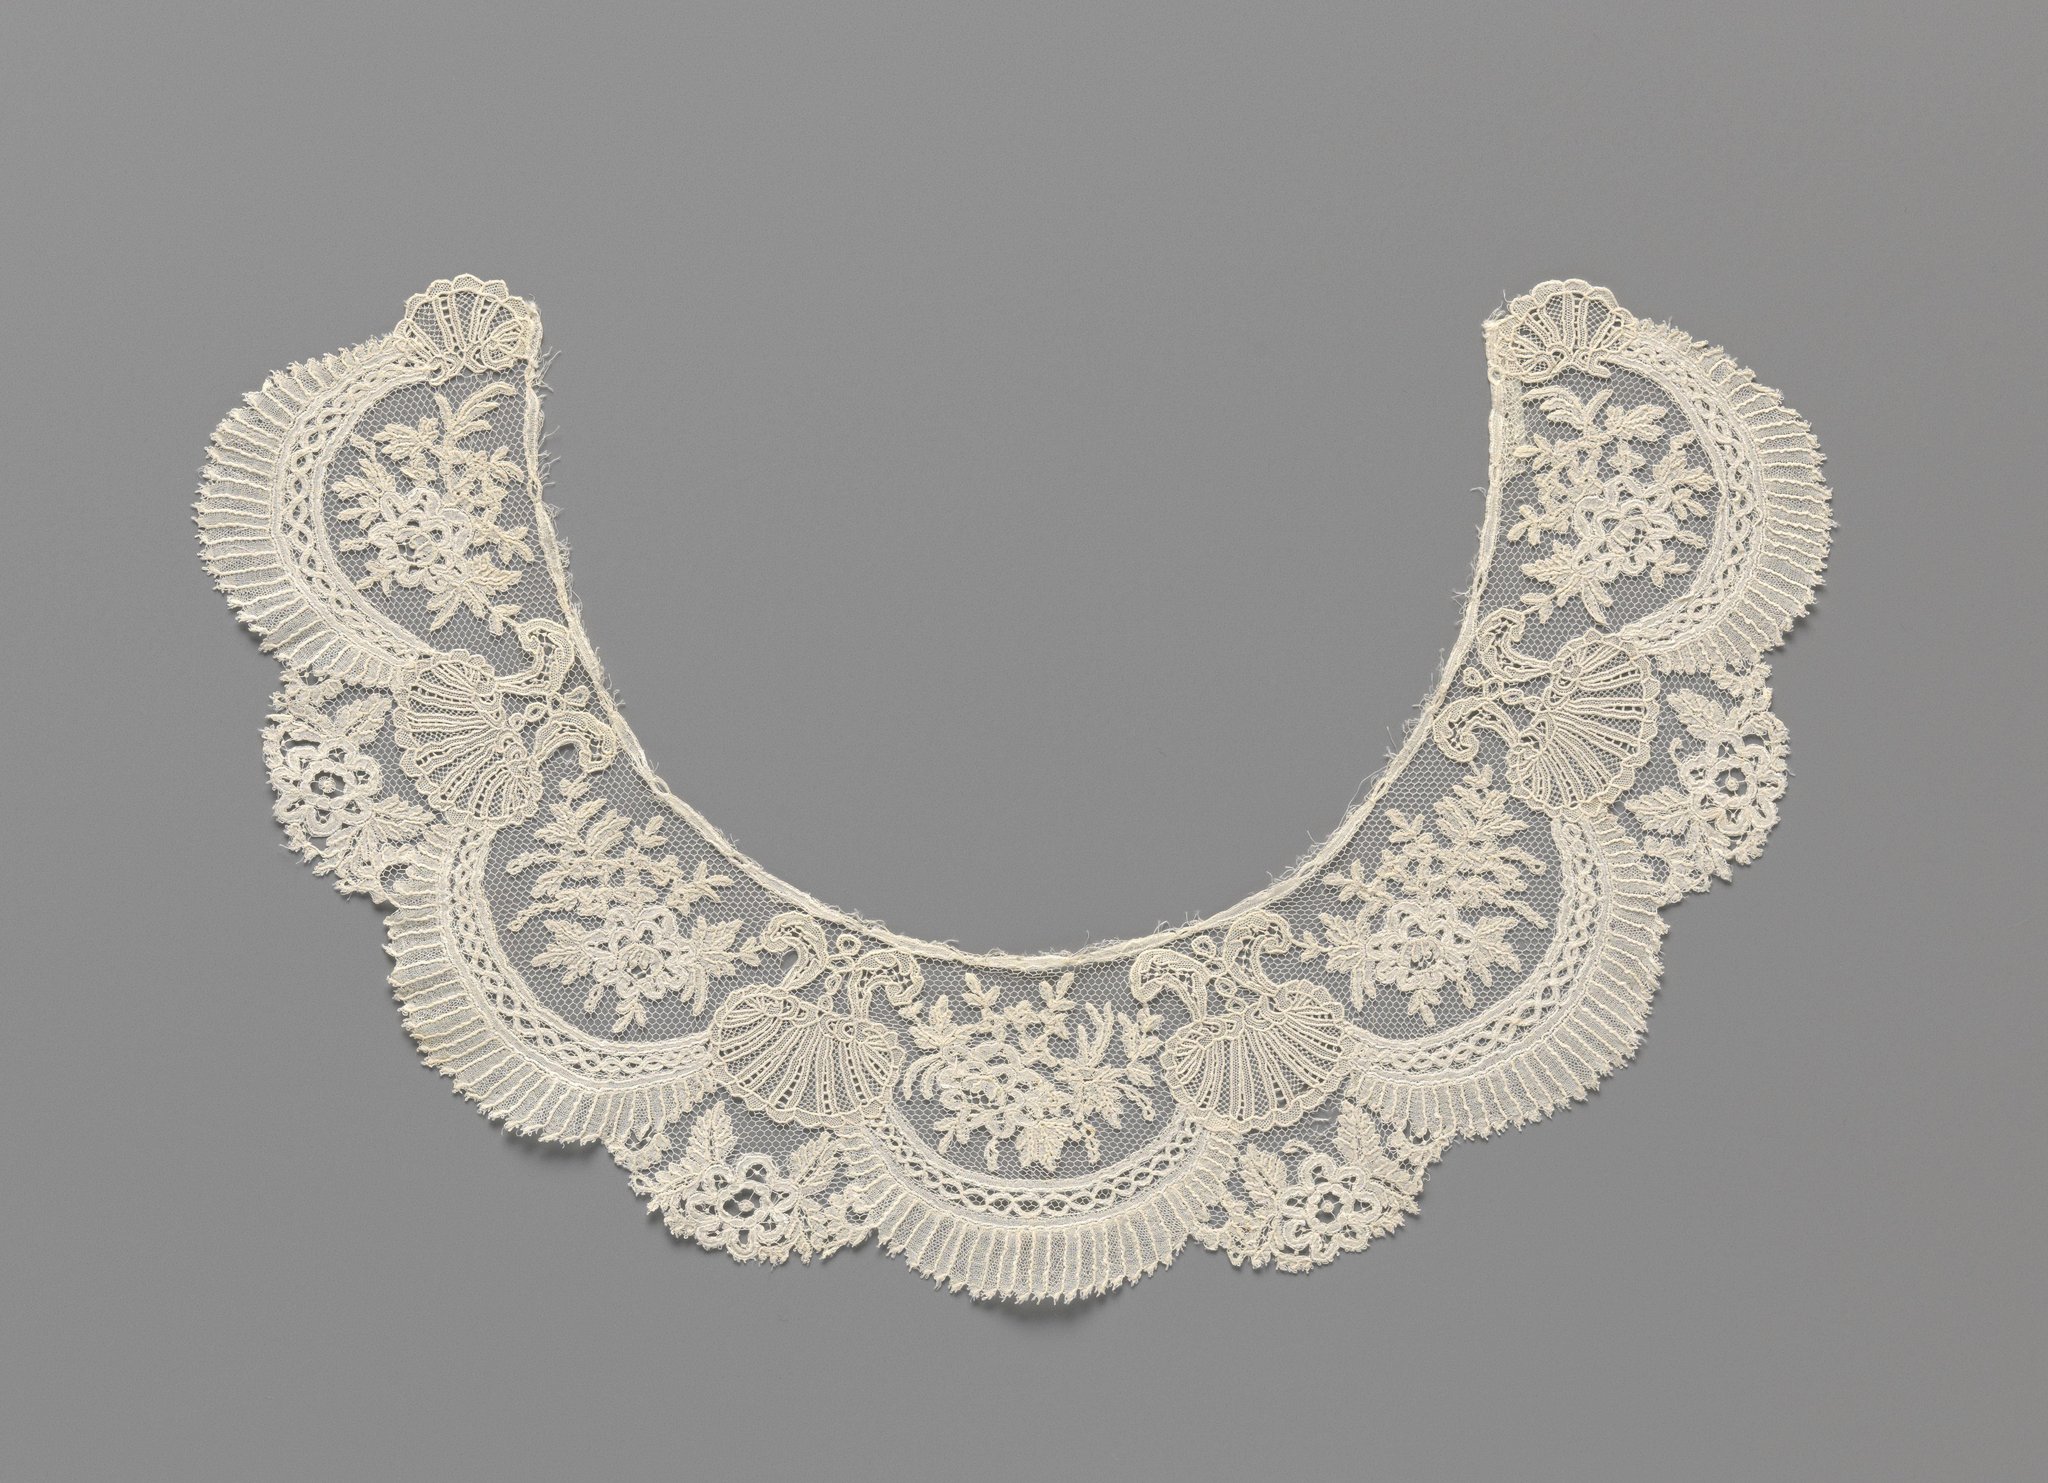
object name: womenswear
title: Kraag van applicatiekant met vijf grote schulpen waartussen vier kleinere met een rozetbloem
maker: Anonymous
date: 1850-1870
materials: linen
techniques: lace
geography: brussels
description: Kraag van naturelkleurige Brusselse applicatiekant: gemengde kant - naaldkant in combinatie met kloskant - geappliceerd op machinale tule. Model: tot een halve cirkel gevormde strook. Patroon met vijf grote halfcirkelvormige schulpen, gevormd door een sierlijst van aaneengeschakelde liggende ovaaltjes waaronder langgerekte ovaaltjes hangen. Deze grote schulpen worden afgewisseld door vier kleinere schulpen, gevormd door een rozetbloem omringd door bladeren. In het veld boven elke grote schulp ligt een rozentak, met steeds één grote en drie kleine roosjes tussen bladeren. Boven de andere schulpen staat een schelpmotief in naaldkant met twee c-voluten erboven. Beide uiteinden hebben nog twee schelpen. Met uitzondering van de schelpen, die zijn gemaakt van naaldkant, zijn de andere motieven grotendeels geklost in linnenslag met glimmende contourdraden. Draadbundels zijn gebruikt om met reliëfcontouren bladnerven te accentueren en ze zijn gebruikt tussen de hangende ovaaltjes in de sierlijst van de grote schulpen. Deze ovaaltjes zijn om en om in linnenslag en netslag geklost. In de bloemharten van de gekloste grotere bloemen zijn naaldkant siersteken toegepast.